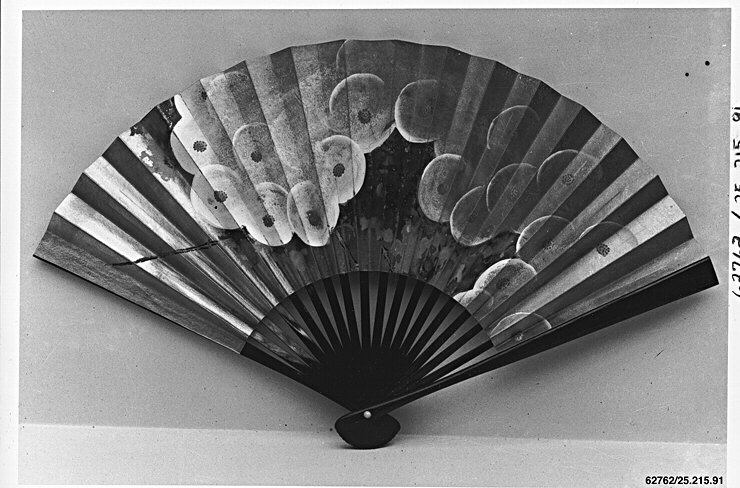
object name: folding fan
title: Fan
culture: japanese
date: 1901-2000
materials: metal, paint, paper